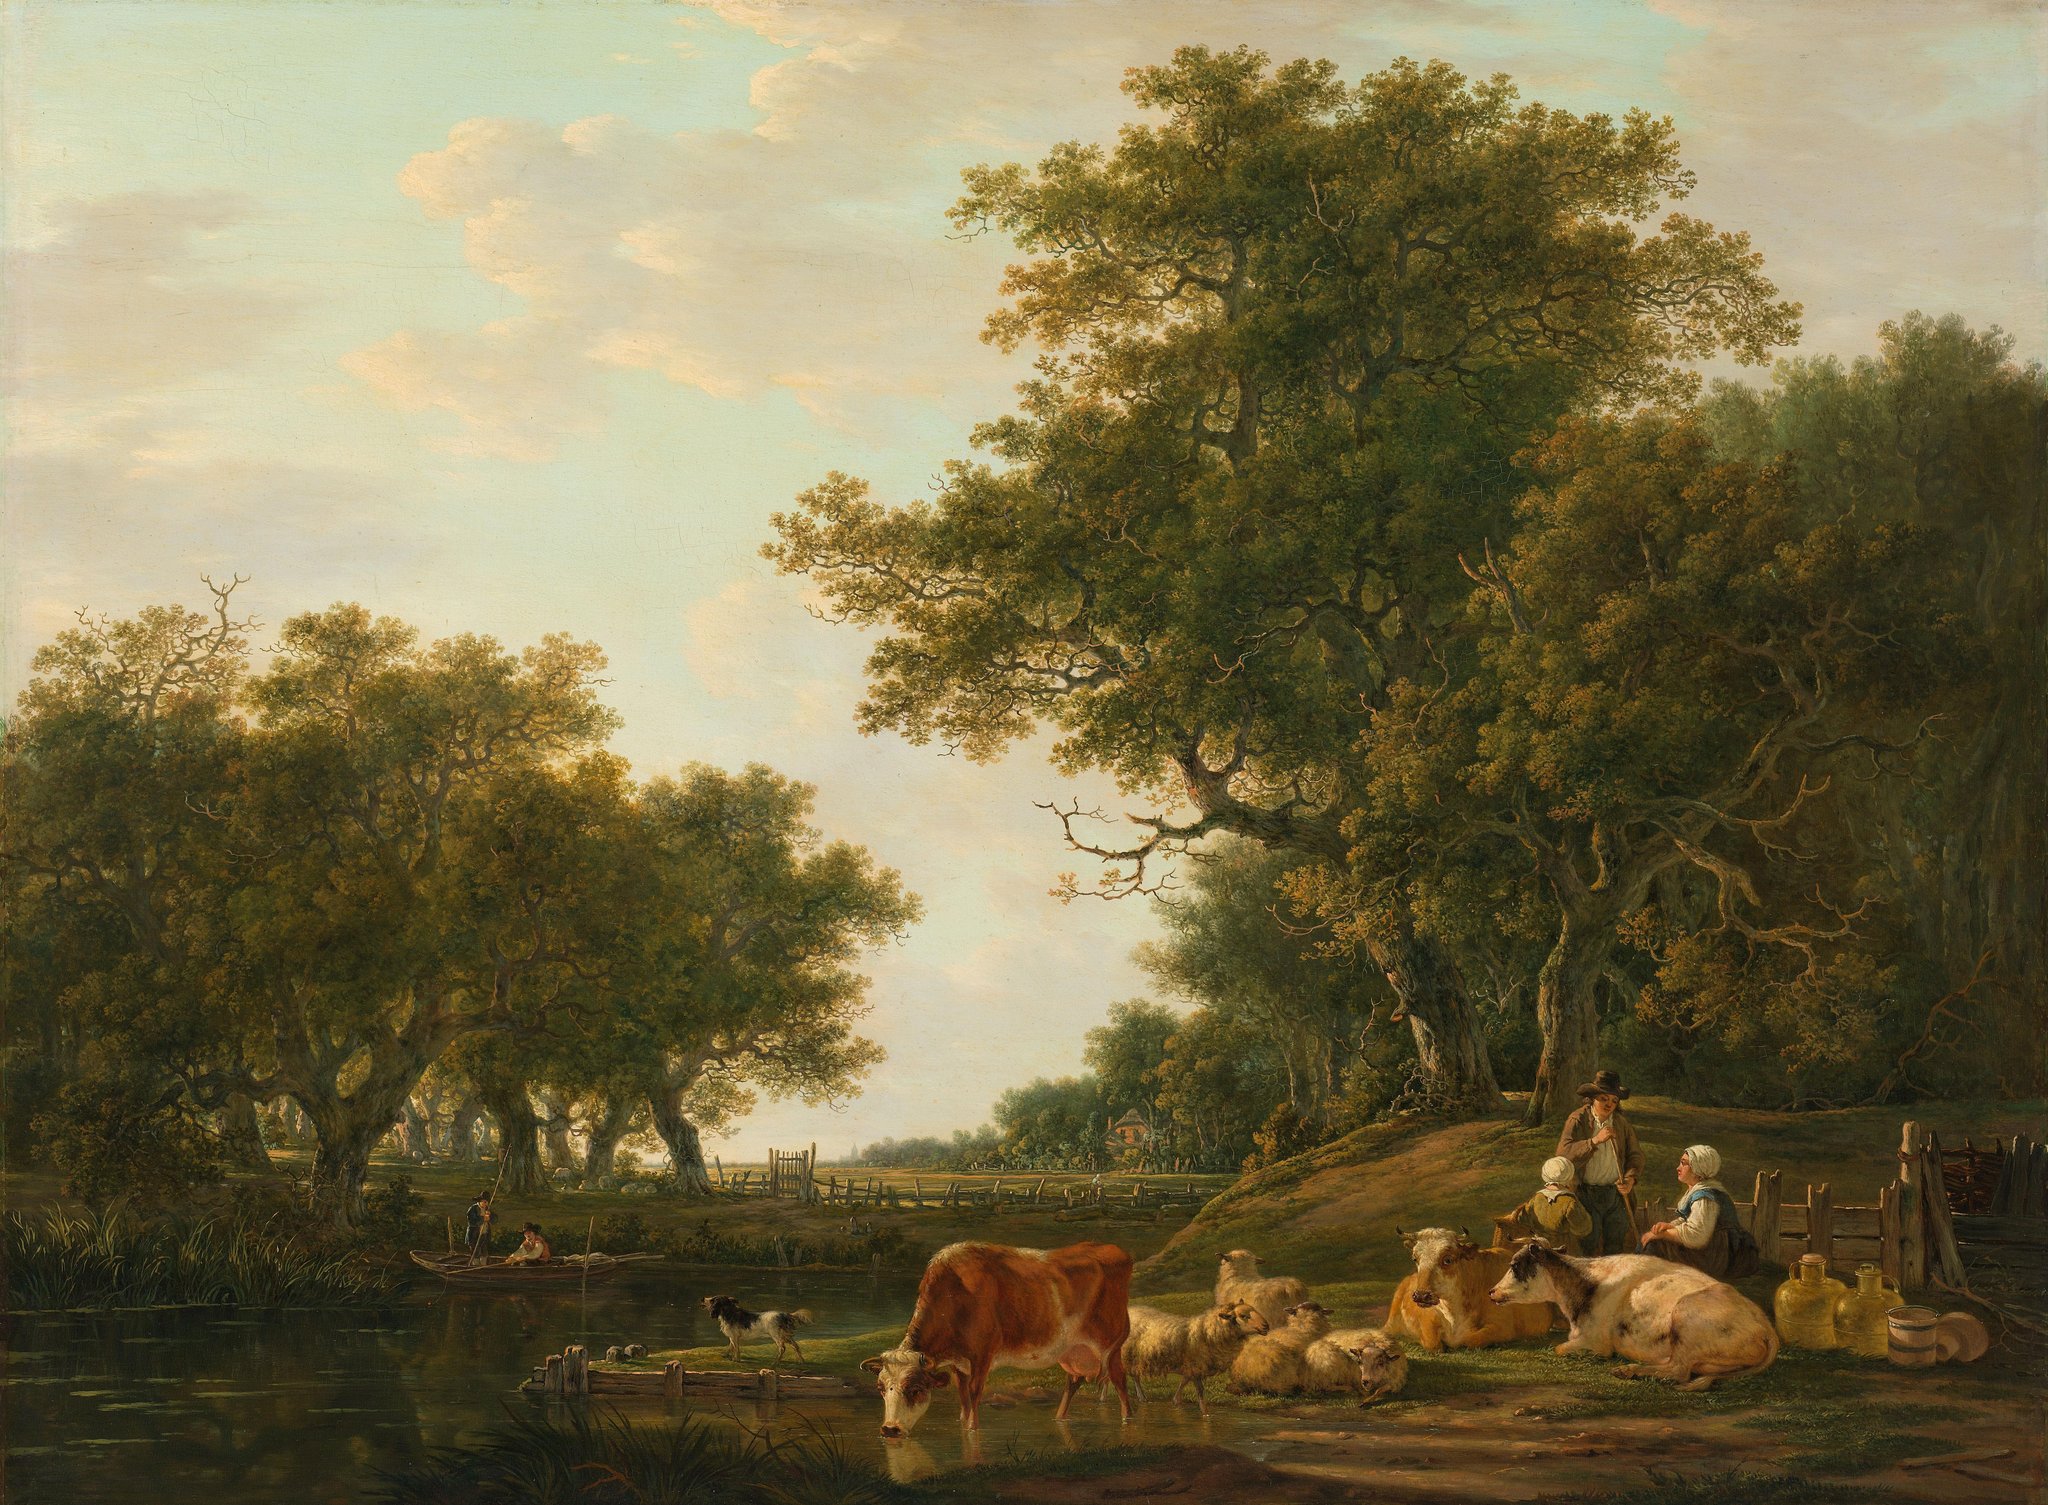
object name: painting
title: Landscape with Peasants with their Cattle and Anglers on the Water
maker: jacob van strij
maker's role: draughtsman, painter, print maker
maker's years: 1756-1815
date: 1800-1810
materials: oil, panel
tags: herding, herdsman, herdswoman, shepherd, shepherdess, cowherd, etc., cattle, milkmaid, angling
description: Landschap met een herder die een praatje maakt met twee melkmeiden, de koeien en schapen liggen bij de oever van een plas. Rechts bij een schutting staan melkbussen en emmers. Links twee mannen met hengels in een roeibootje. Op de achtergrond hoge bomen. Het schilderij staat ook bekend onder de naam 'Het testament van Van Strij'.